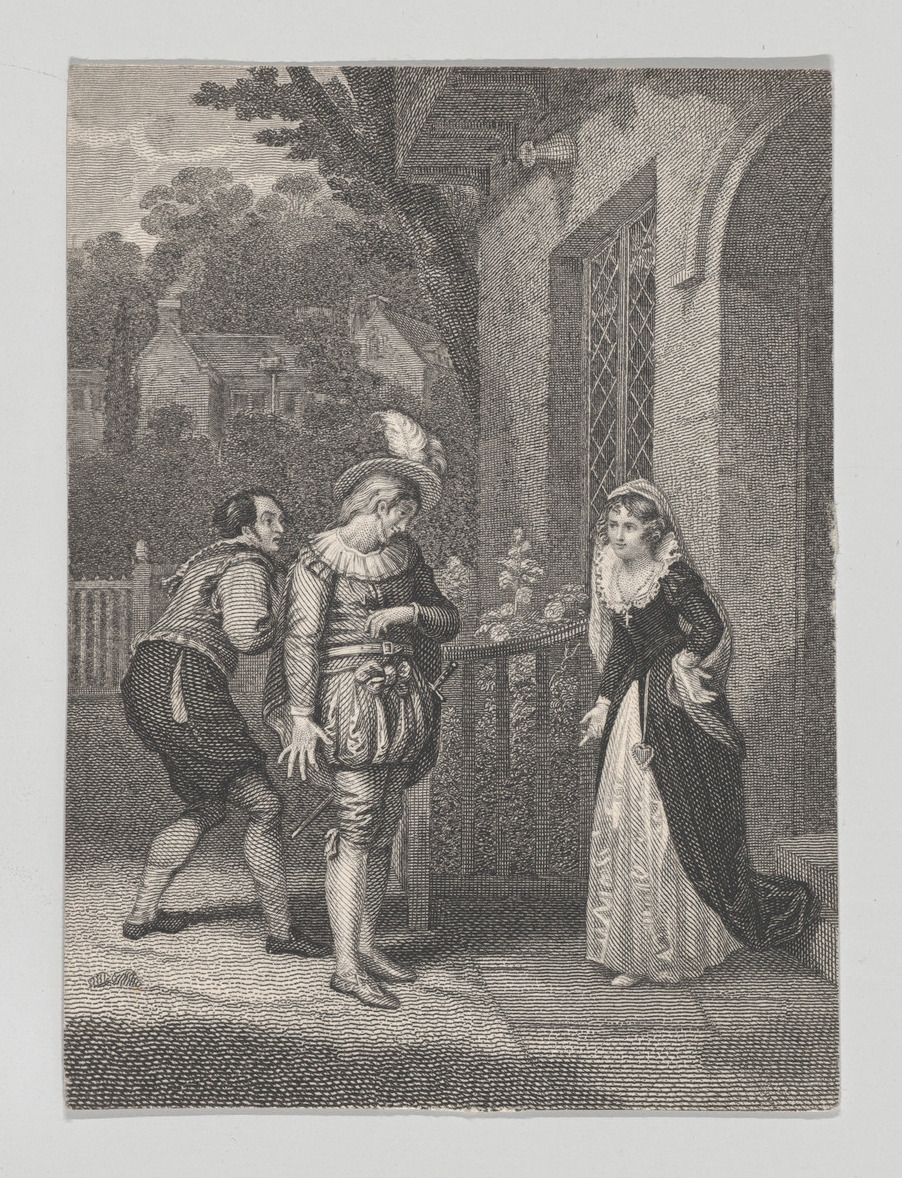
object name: print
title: Anne Page, Slender and Simple (Shakespeare, Merry Wives of Windsor, Act 1, Scene 1)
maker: charles heath, the elder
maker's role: engraver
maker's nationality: british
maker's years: 1785-1848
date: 1825-1840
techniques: engraving, etching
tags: shakespeare,men,women